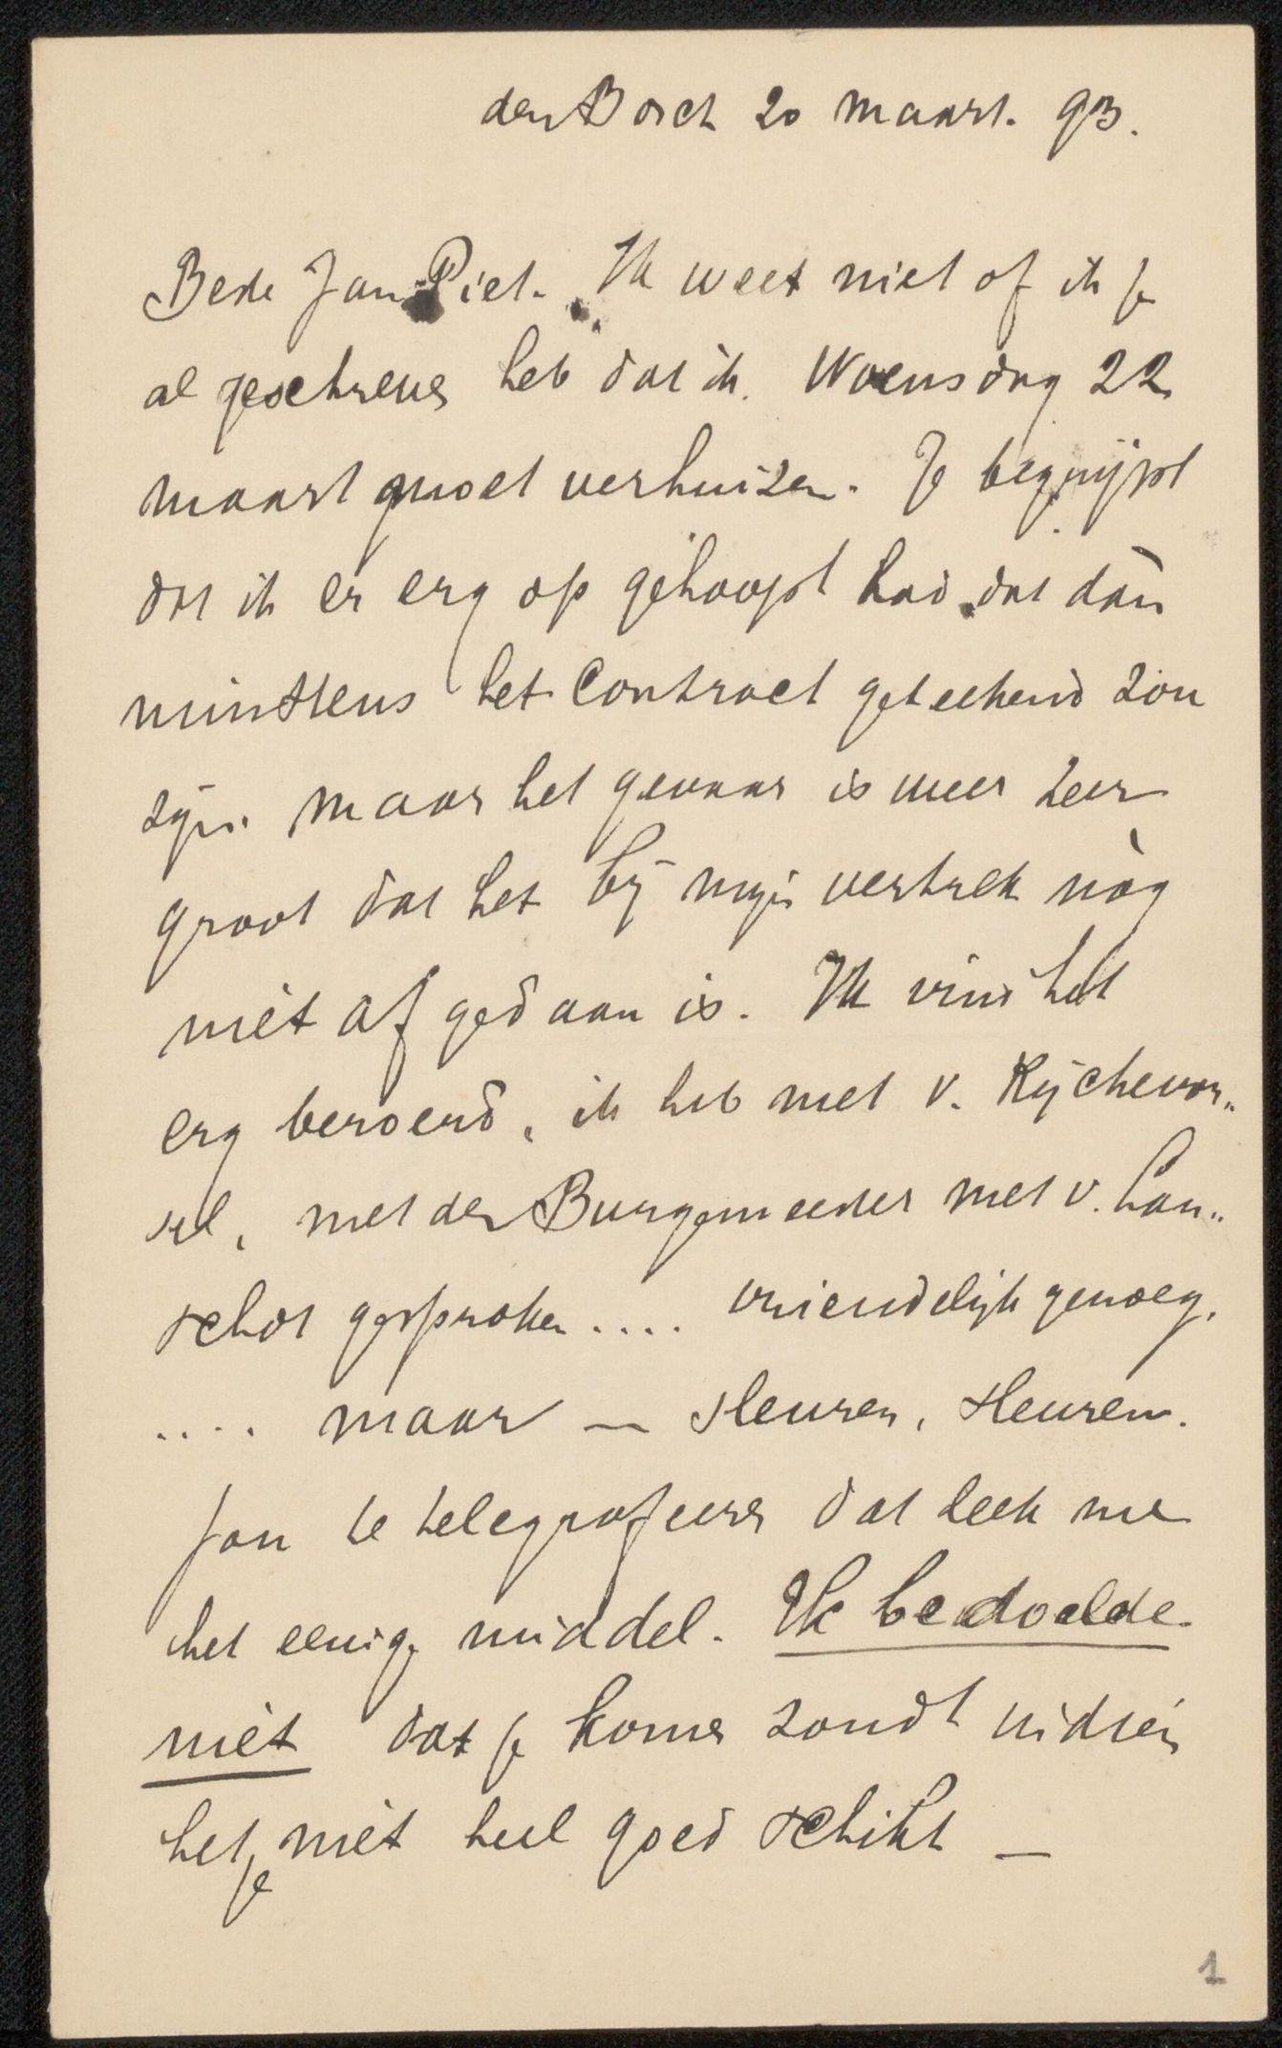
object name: letter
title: Brief aan Jan Veth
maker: antoon derkinderen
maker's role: draughtsman, painter, print maker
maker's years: 1859-1925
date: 1893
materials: ink, paper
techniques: pen, writing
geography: den bosch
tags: dordrecht, painter, print maker, draughtsman, designer, jan veth, money, den bosch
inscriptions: collector's mark: ‘RPK’